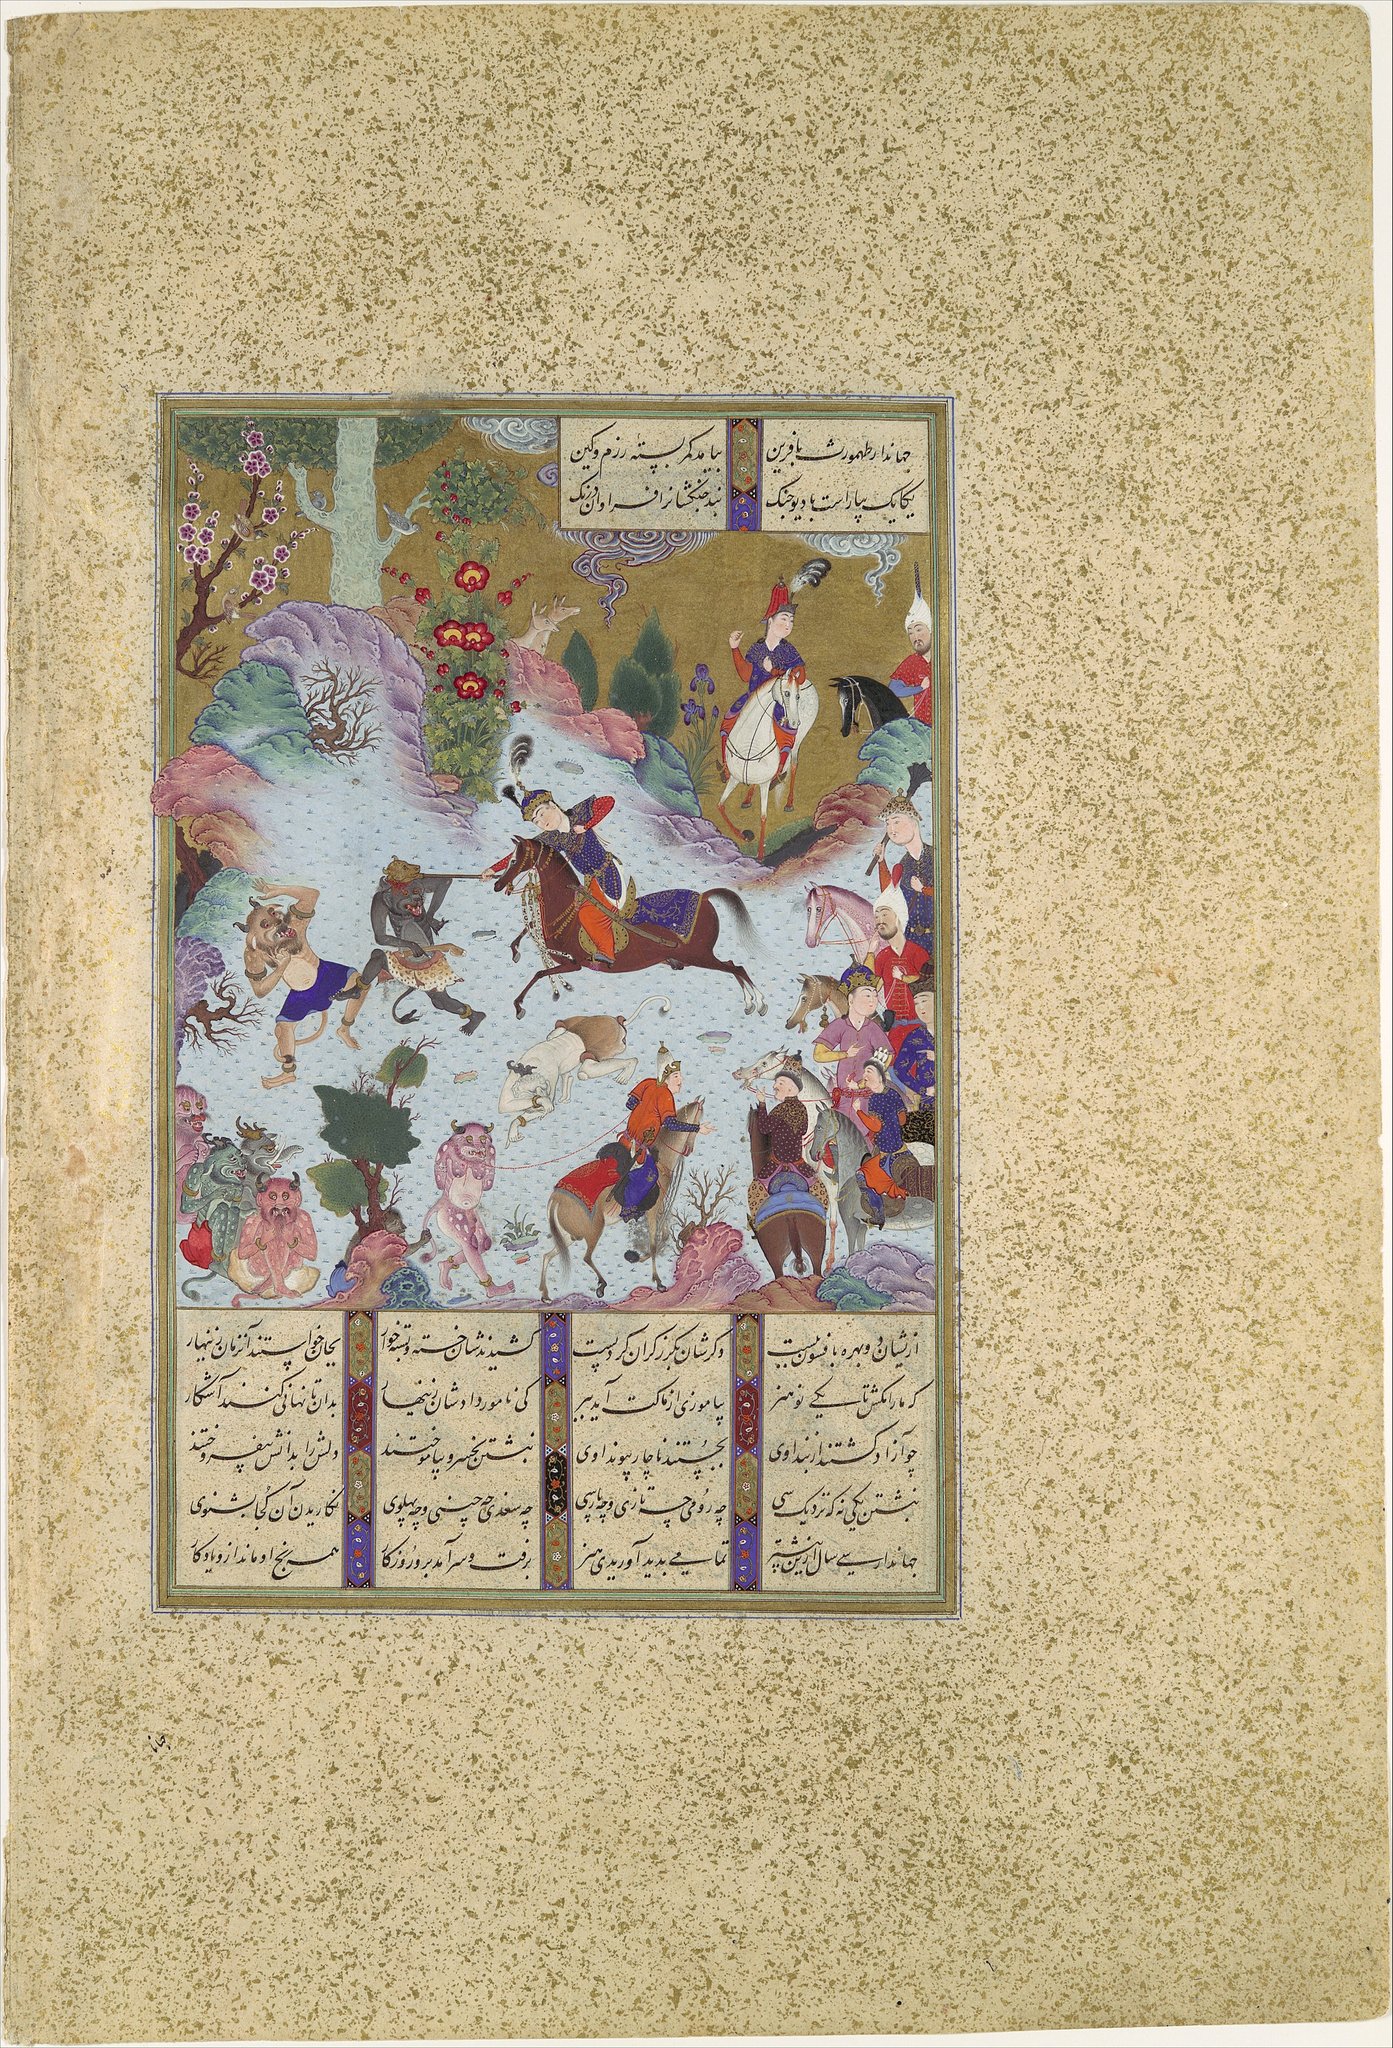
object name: folio from an illustrated manuscript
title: "Tahmuras Defeats the Divs", Folio 23v from the Shahnama (Book of Kings) of Shah Tahmasp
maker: abu'l qasim firdausi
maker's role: author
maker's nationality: iranian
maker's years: 935-1020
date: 1525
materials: gold, ink, paper, silver, watercolor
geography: iran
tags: men,horses,demons